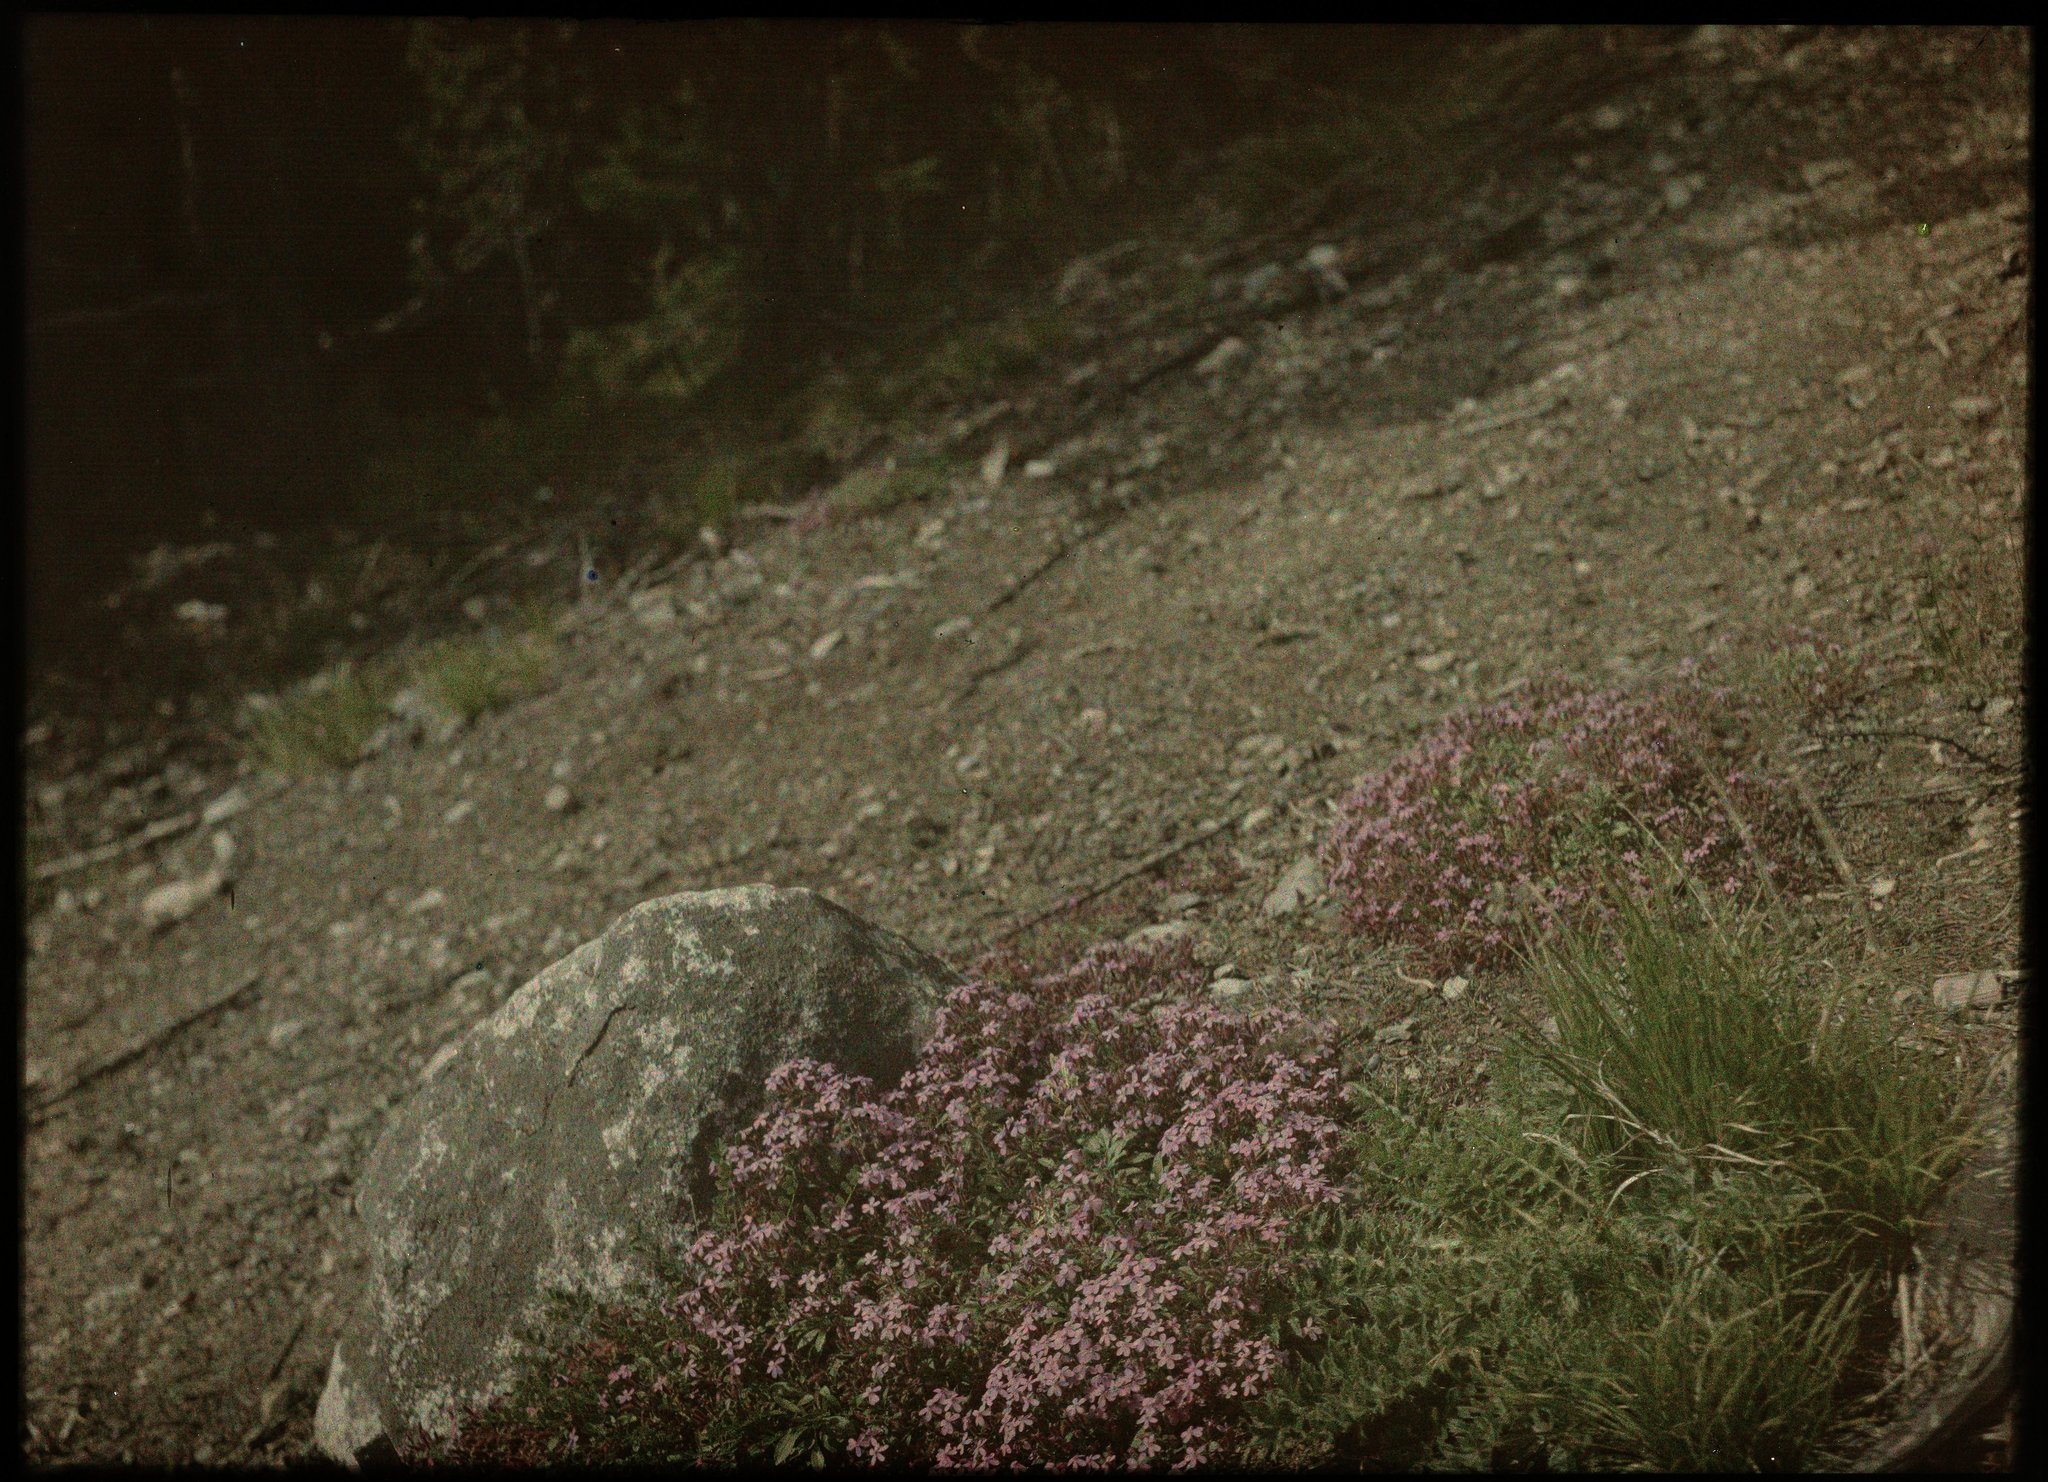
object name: photograph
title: Bloemen op steen-/rotsbodem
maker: adolphe burdet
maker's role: fotograaf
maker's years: 1860-1940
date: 1907-1930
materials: glass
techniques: autochrome process, slide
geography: netherlands